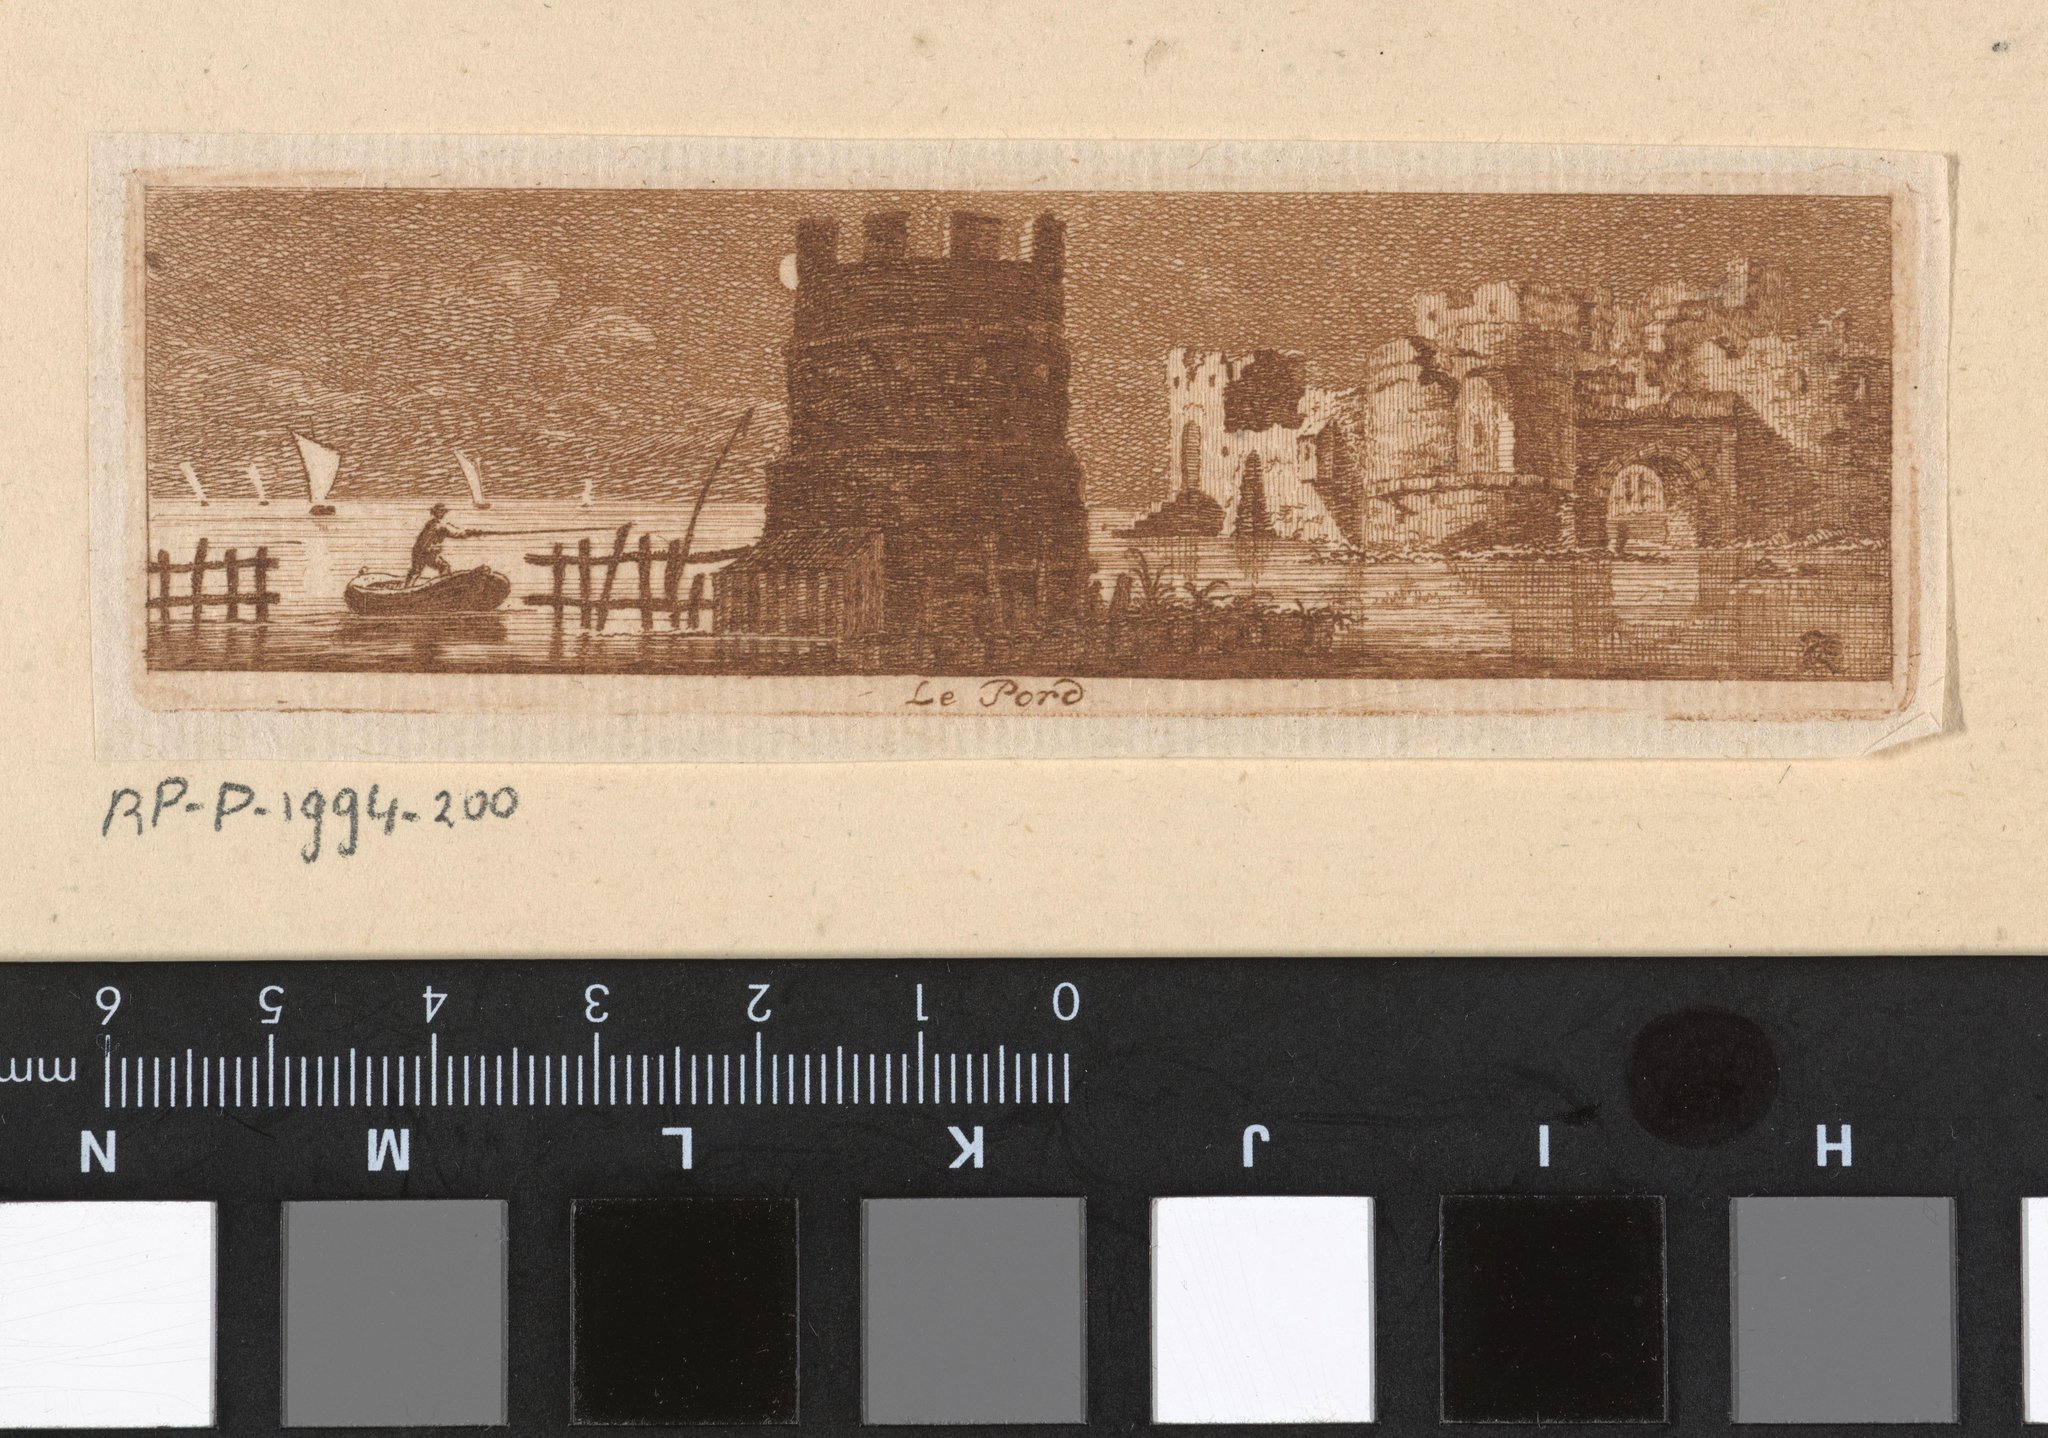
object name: print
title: Havengezicht bij nacht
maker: caspar jacobsz. philips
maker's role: draughtsman, print maker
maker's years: 1732-1789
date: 1766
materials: paper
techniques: etching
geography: amsterdam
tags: river, landscape with ruins, night ~ landscape (sometimes titled 'nox')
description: Havengezicht bij nacht met op de voorgrond de ruïne van een toren. Op de rivier vaart een man in een roeiboot.